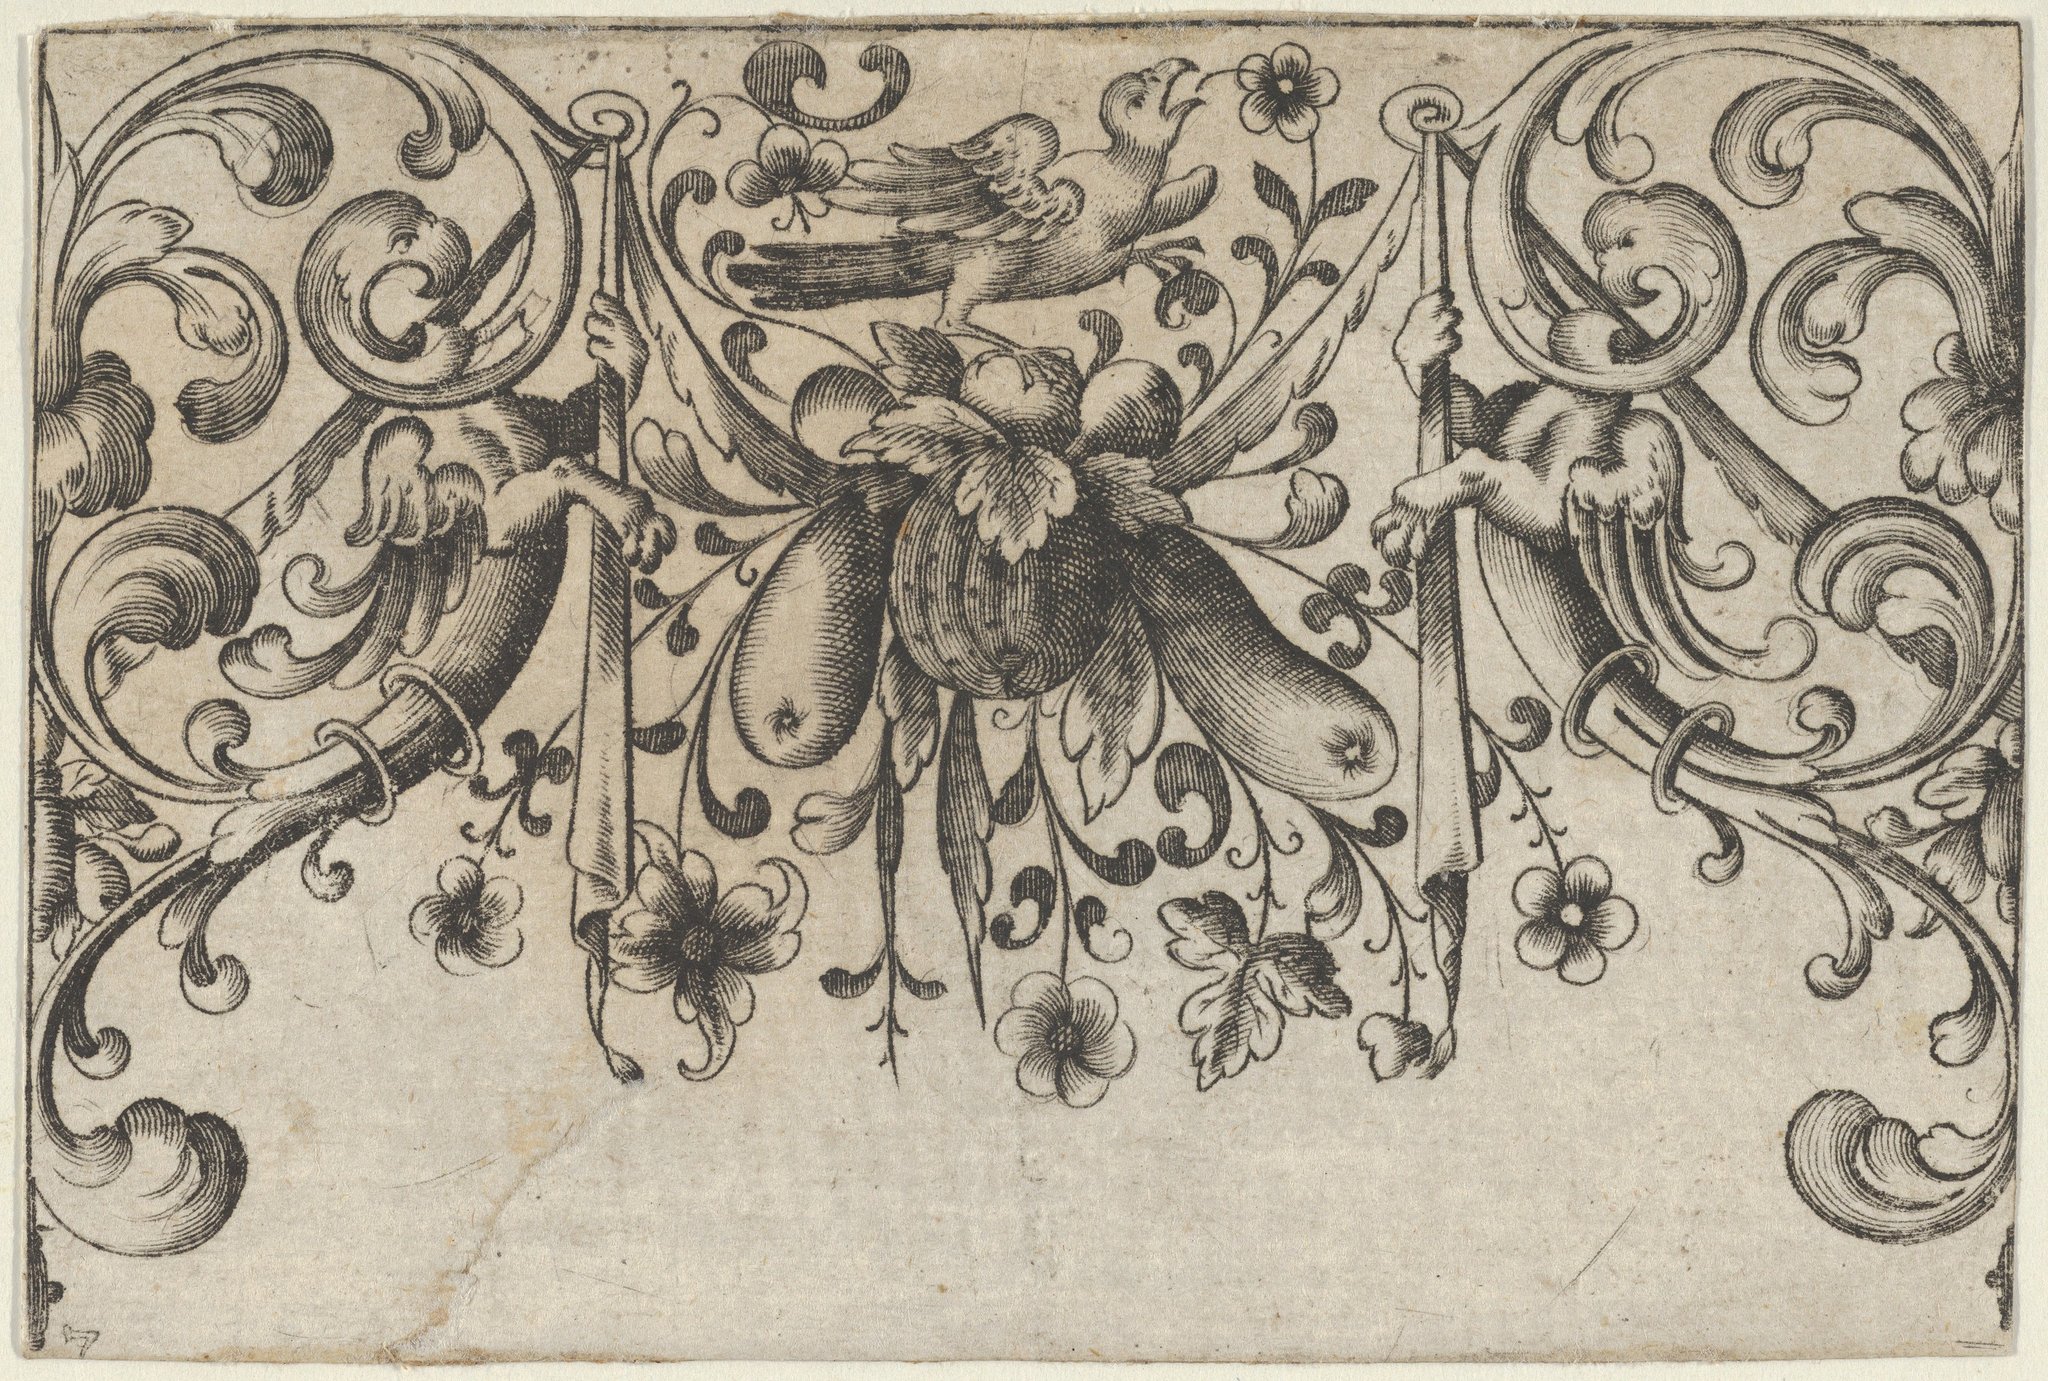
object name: print ornament architecture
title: Design for Silverwork with Garlands, Birds, and Grotesque Motifs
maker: hieronymus bang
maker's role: artist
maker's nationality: german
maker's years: 1553-1630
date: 1568-1633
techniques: engraving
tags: birds,garlands,grotesques,ornament